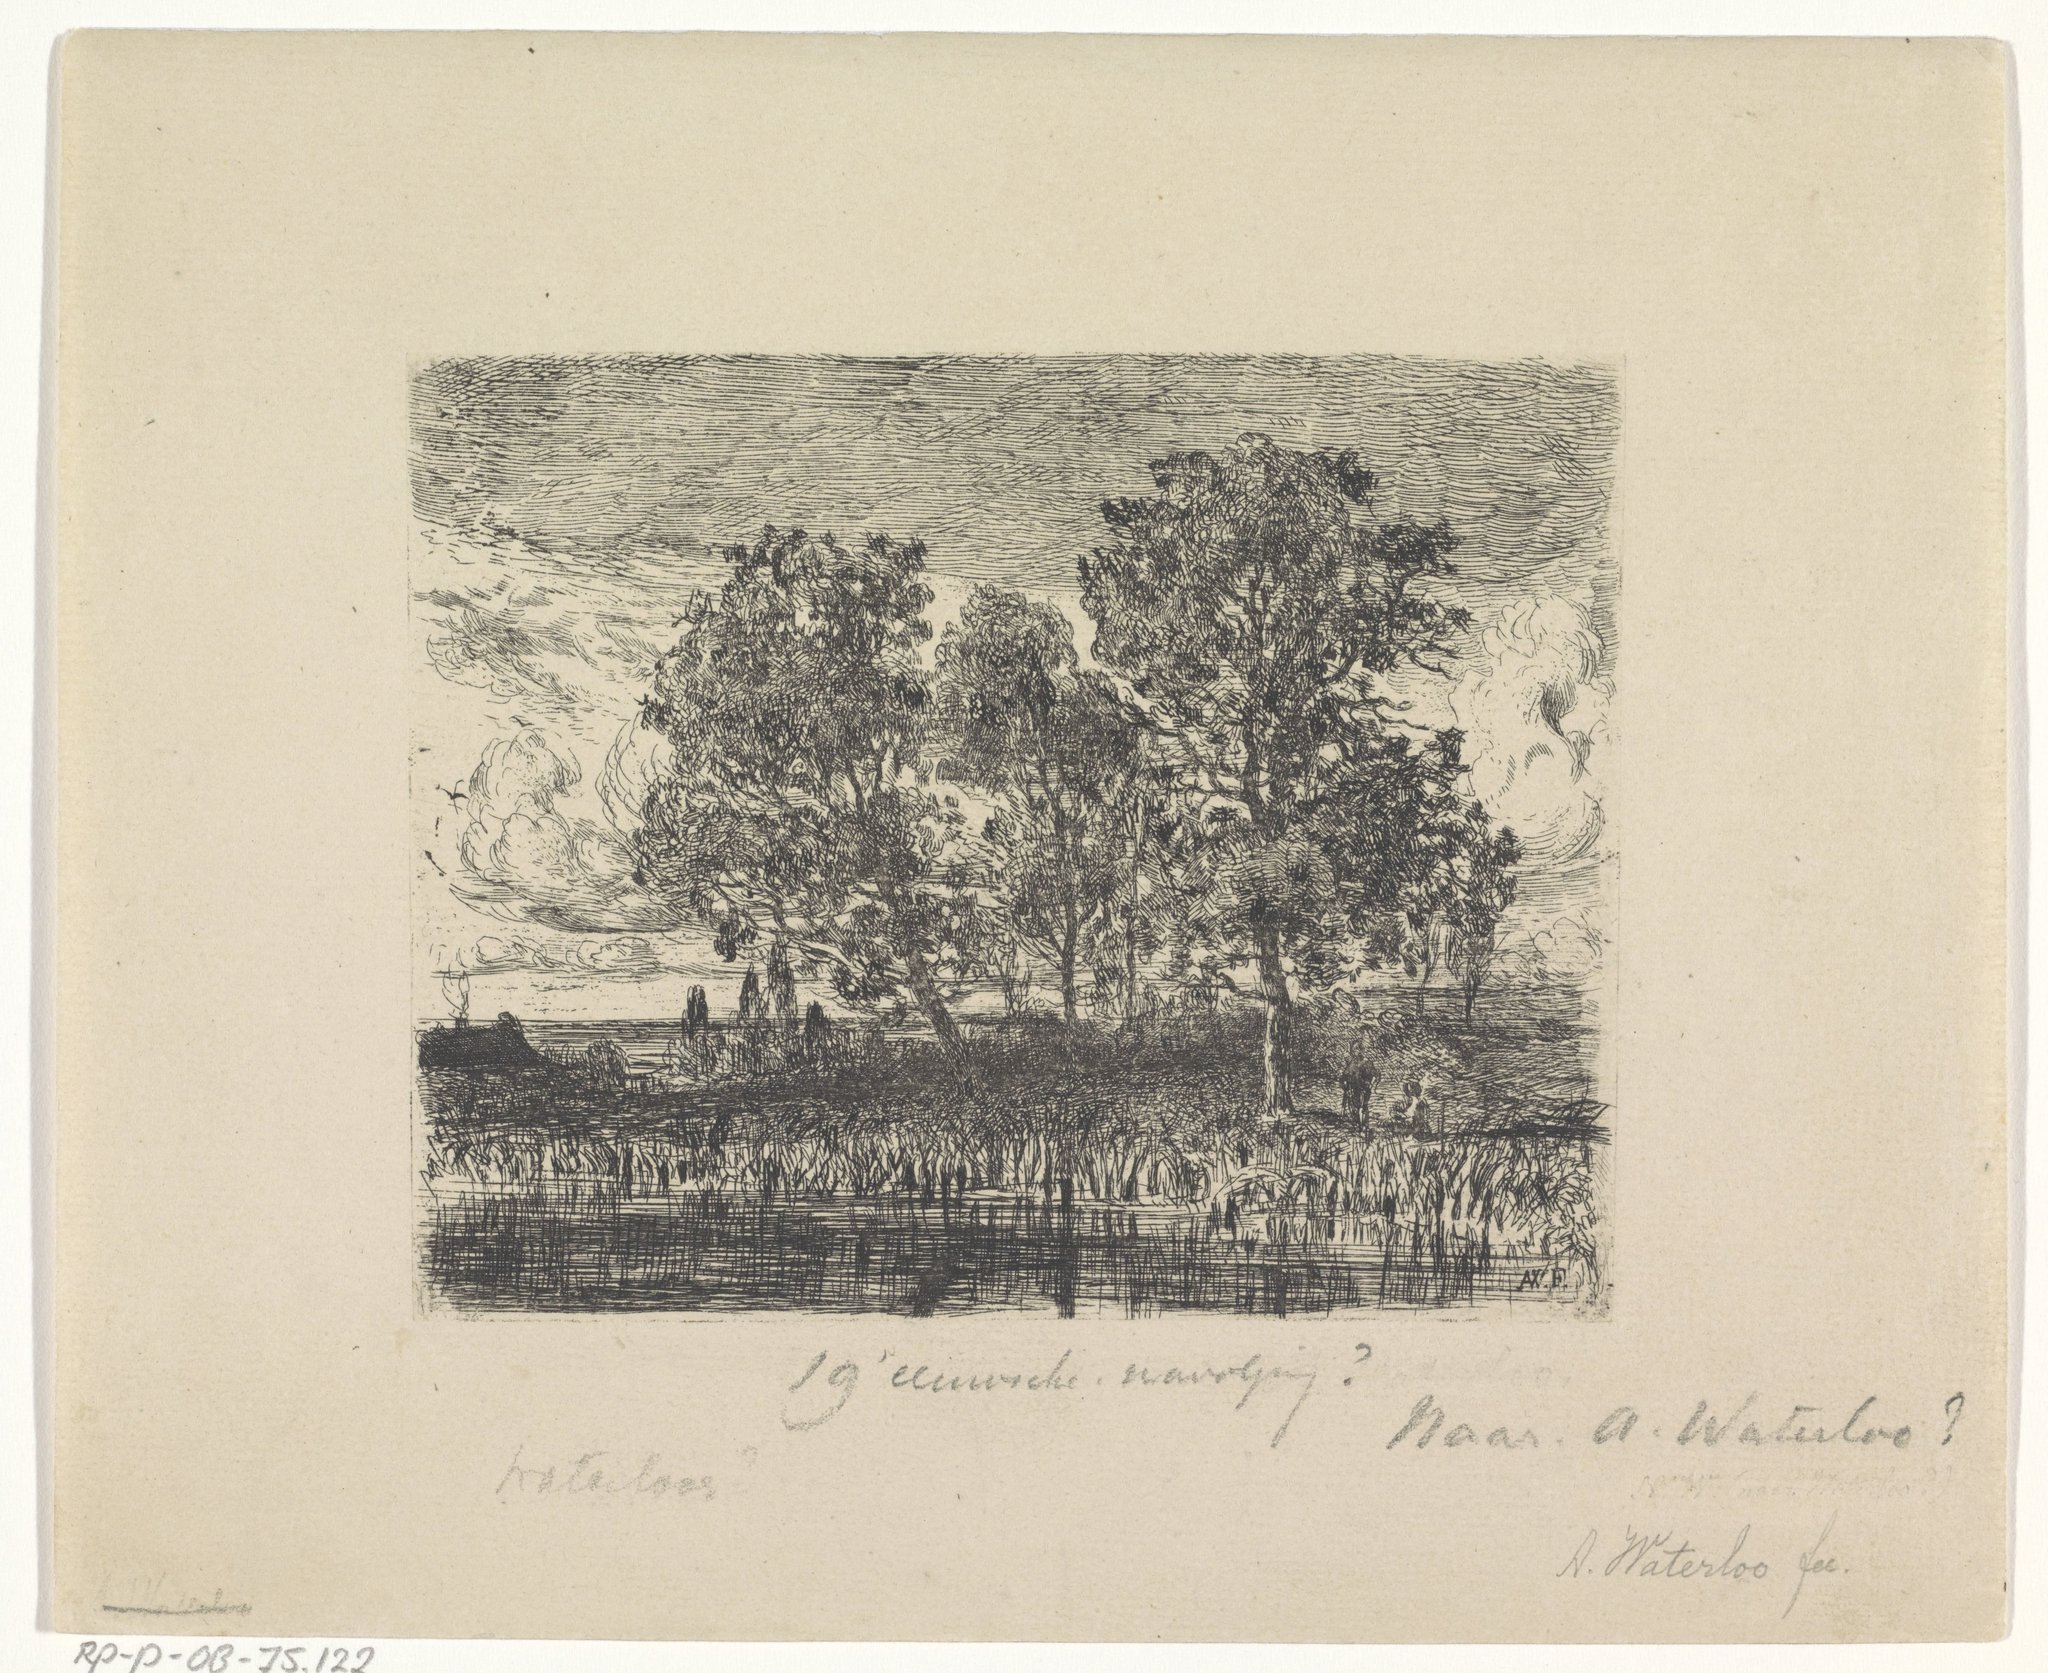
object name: print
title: Landschap met bomen en water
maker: Anonymous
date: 1800-1900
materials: paper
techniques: etching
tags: landscapes in the temperate zone, groups of trees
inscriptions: collector's mark: Lugt 2166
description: Landschap met een groep bomen. Op de voorgrond water.